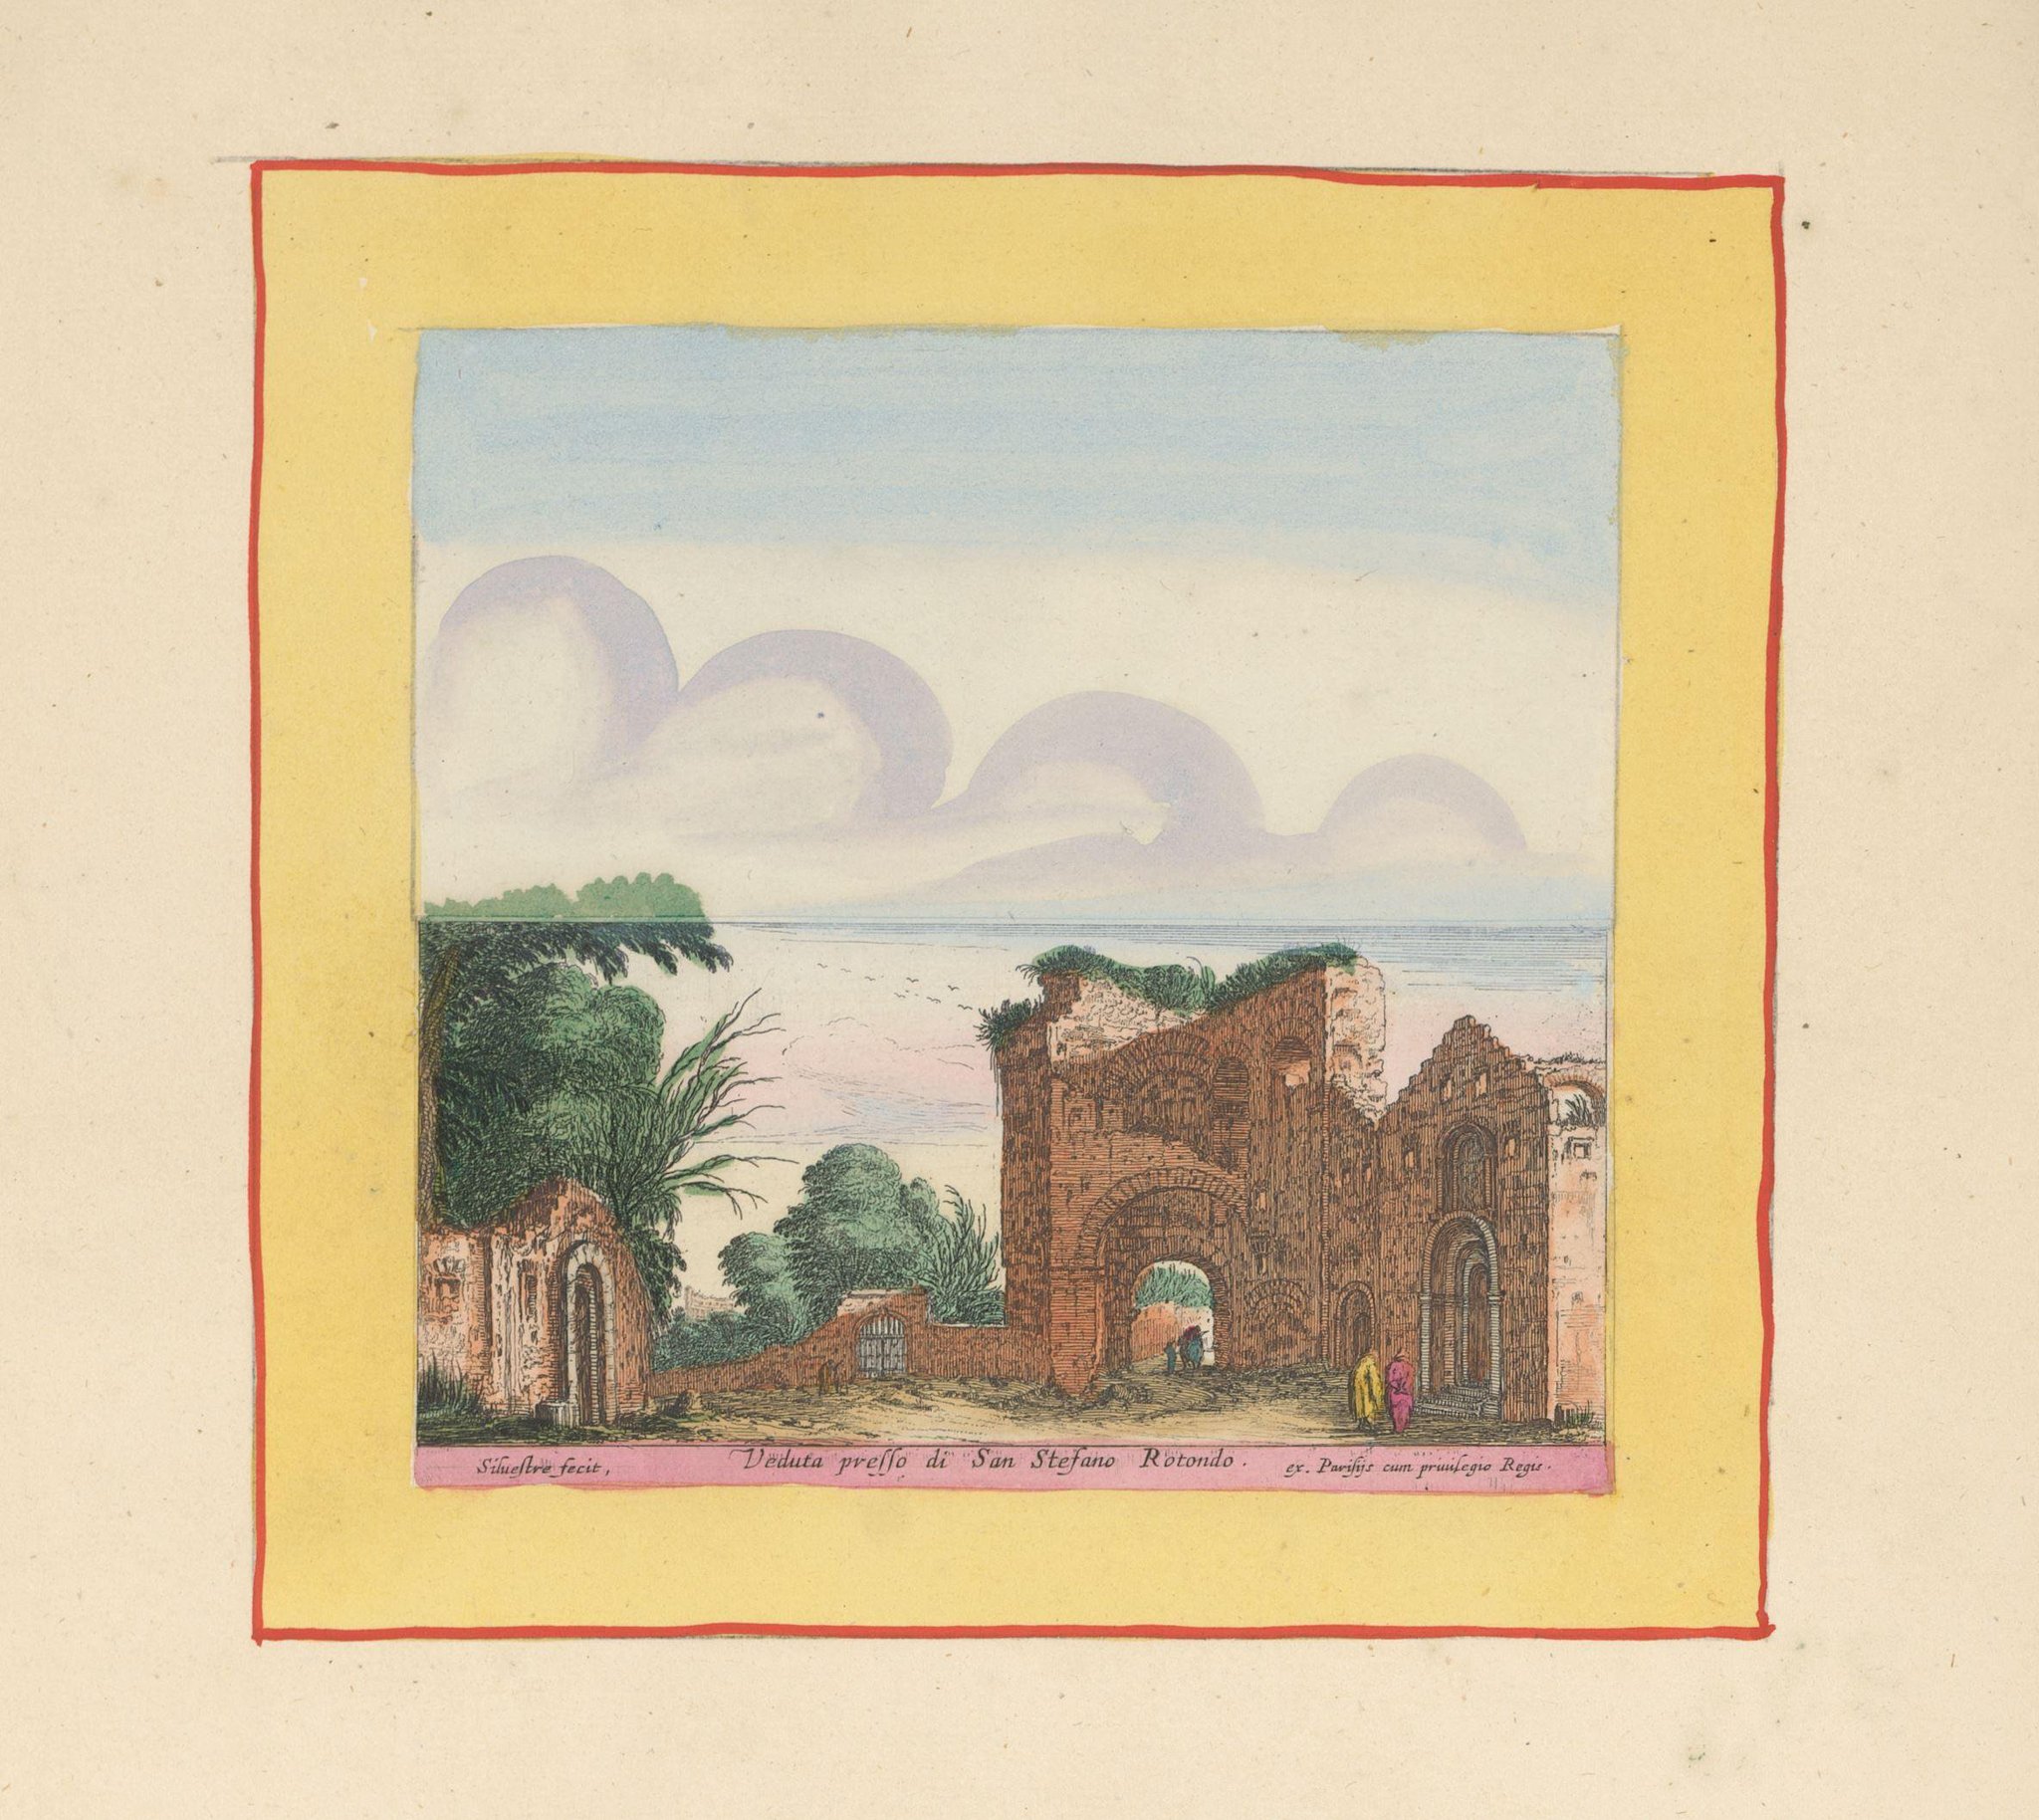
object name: album leaf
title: Landschap nabij de Santo Stefano Rotondo te Rome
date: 1631-1691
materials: paper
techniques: colour, etching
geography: france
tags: ruin of a building ~ architecture, landscape with ruins, rome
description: Prent maakt deel uit van een reeks van twaalf prenten van gezichten op antieke en moderne monumenten in Rome. De prent is langs de bovenrand van de voorstelling afgescheurd. De voorstelling is aan de bovenzijde aangevuld met een geschilderde lucht.